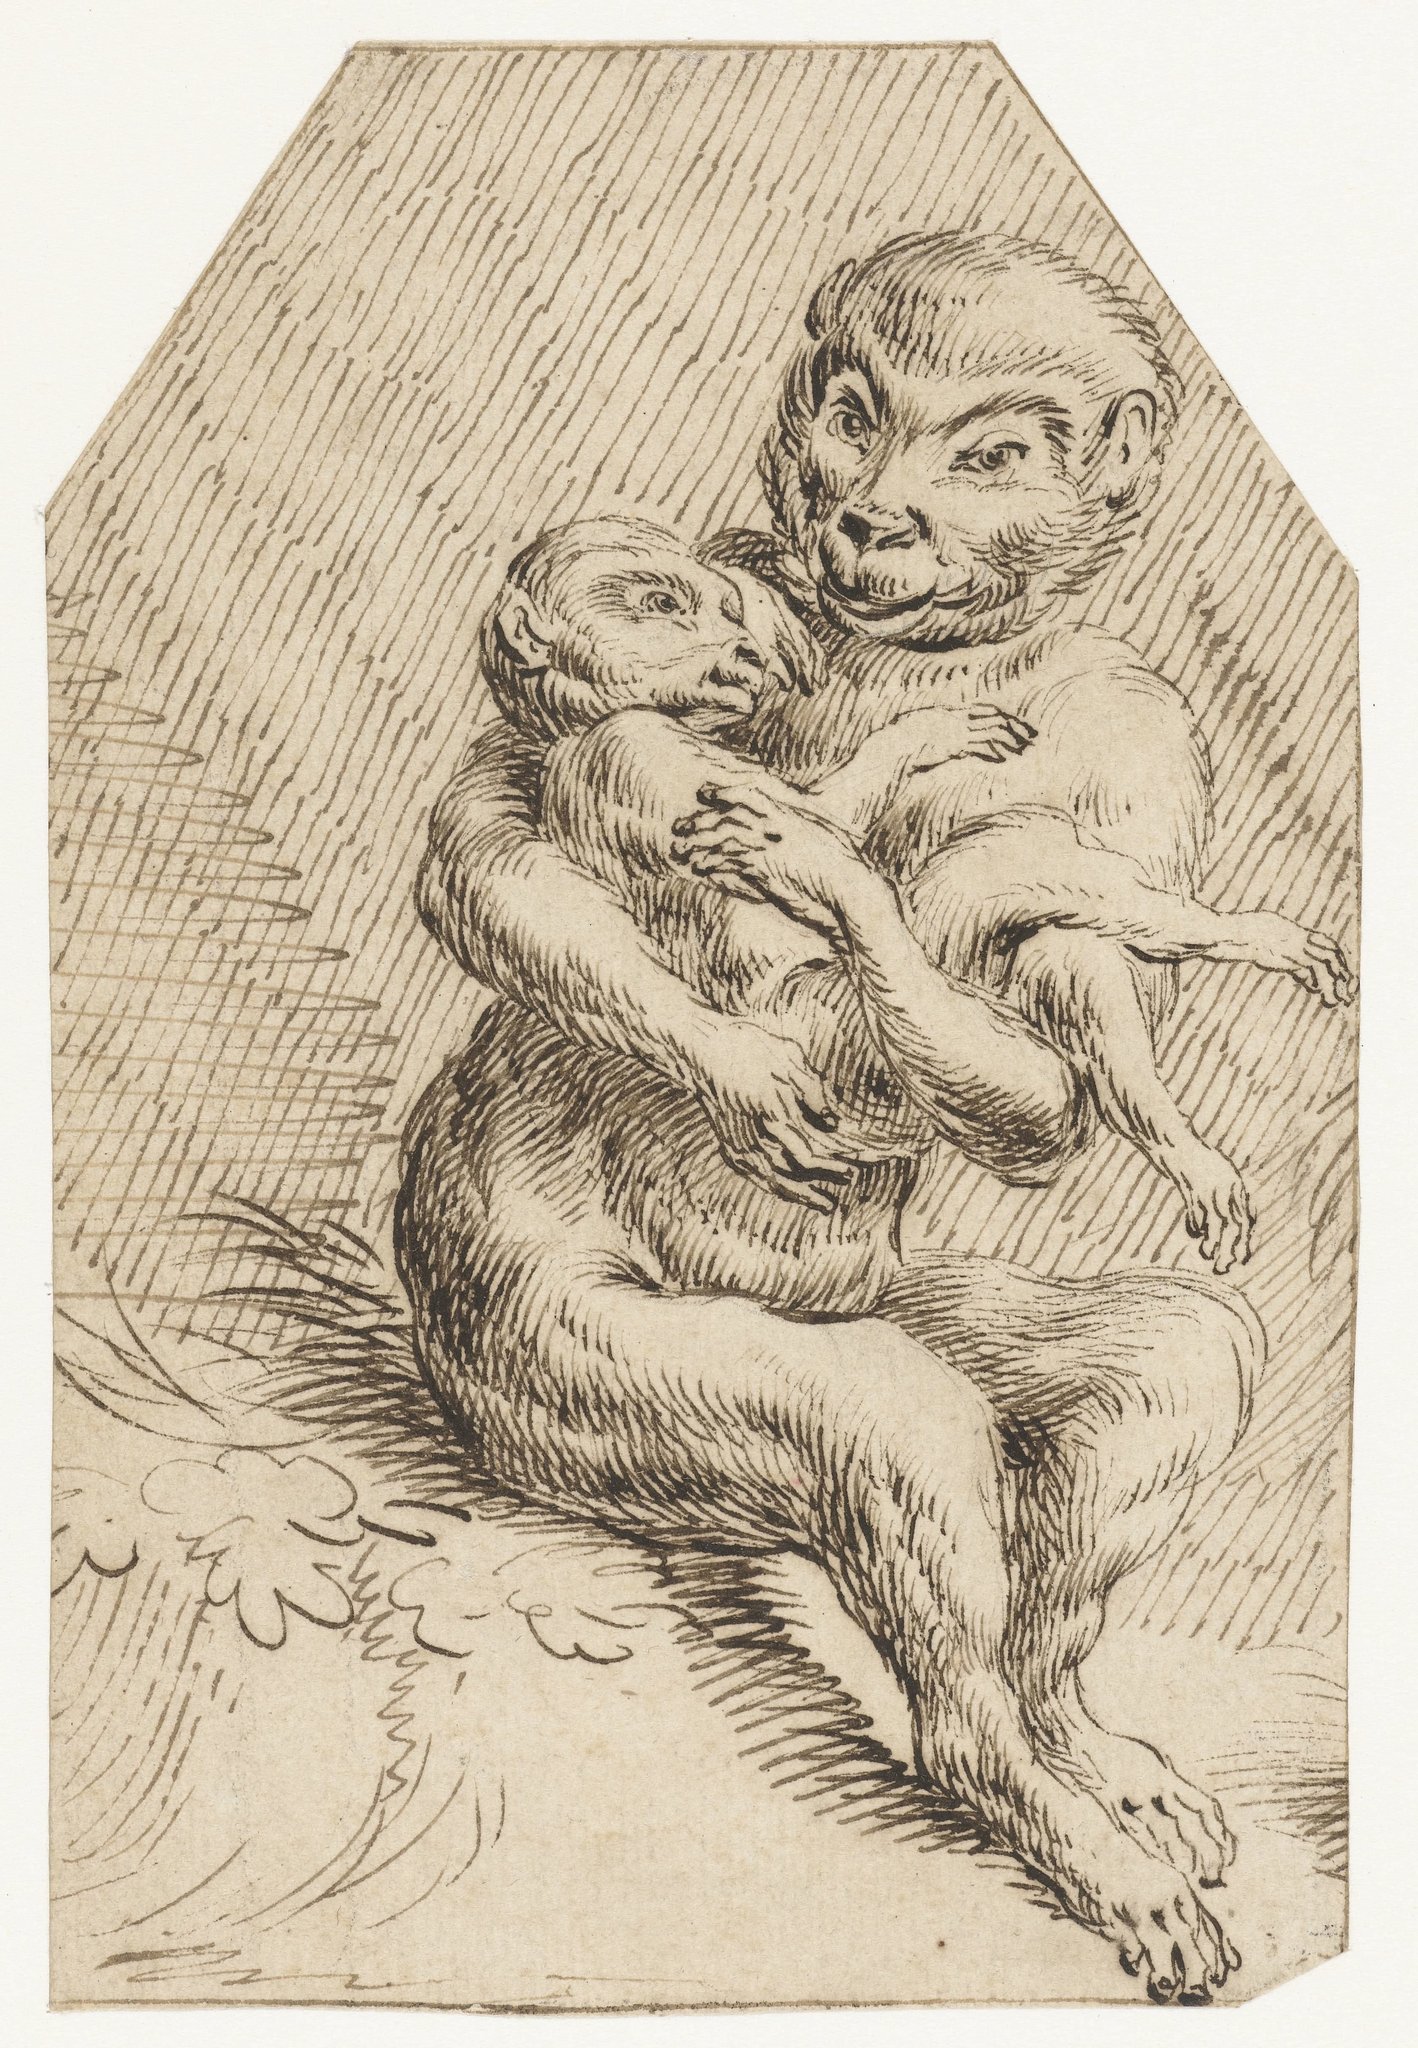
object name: drawing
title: Aap met een jong aapje in zijn armen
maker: Anonymous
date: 1567-1617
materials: ink, paper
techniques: pen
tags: monkeys, apes